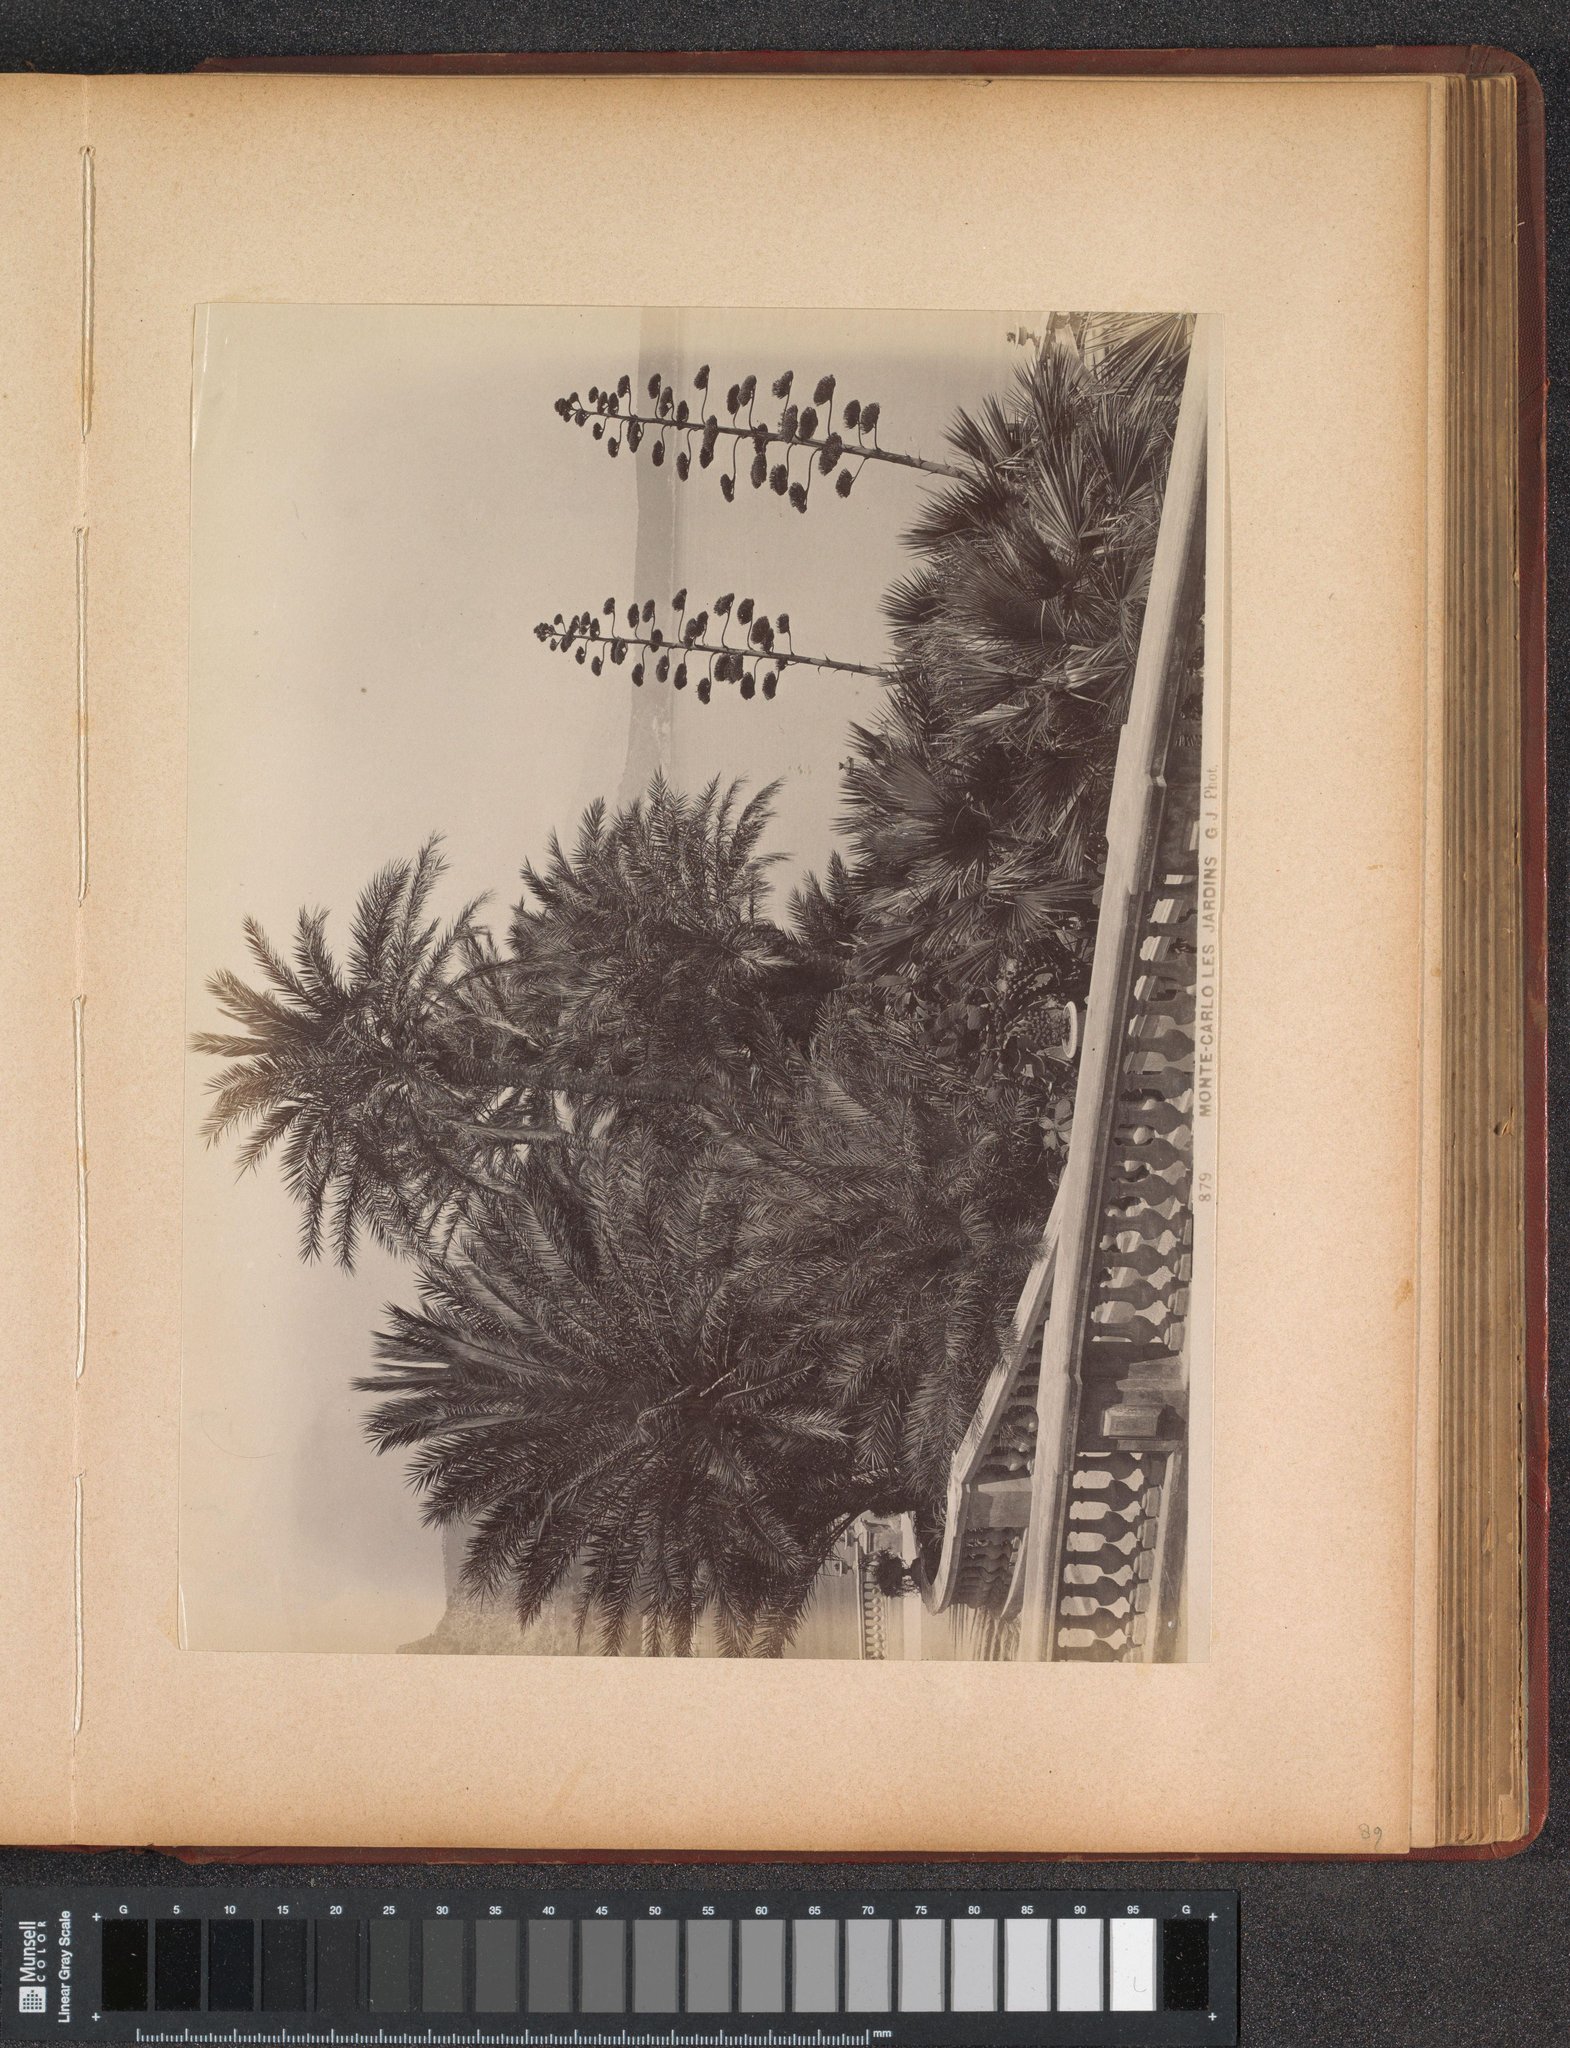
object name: album leaf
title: Monte-Carlo Les jardins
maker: jean gilletta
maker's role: fotograaf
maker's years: 1856-1933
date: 1870-1900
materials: paper, photographic support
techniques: albumen print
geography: monaco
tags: trees: palm-tree, coast, public gardens, park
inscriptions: negative number: ‘879’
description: Onderdeel van Reisalbum met foto's van bezienswaardigheden in Italië en Zuid-Frankrijk.